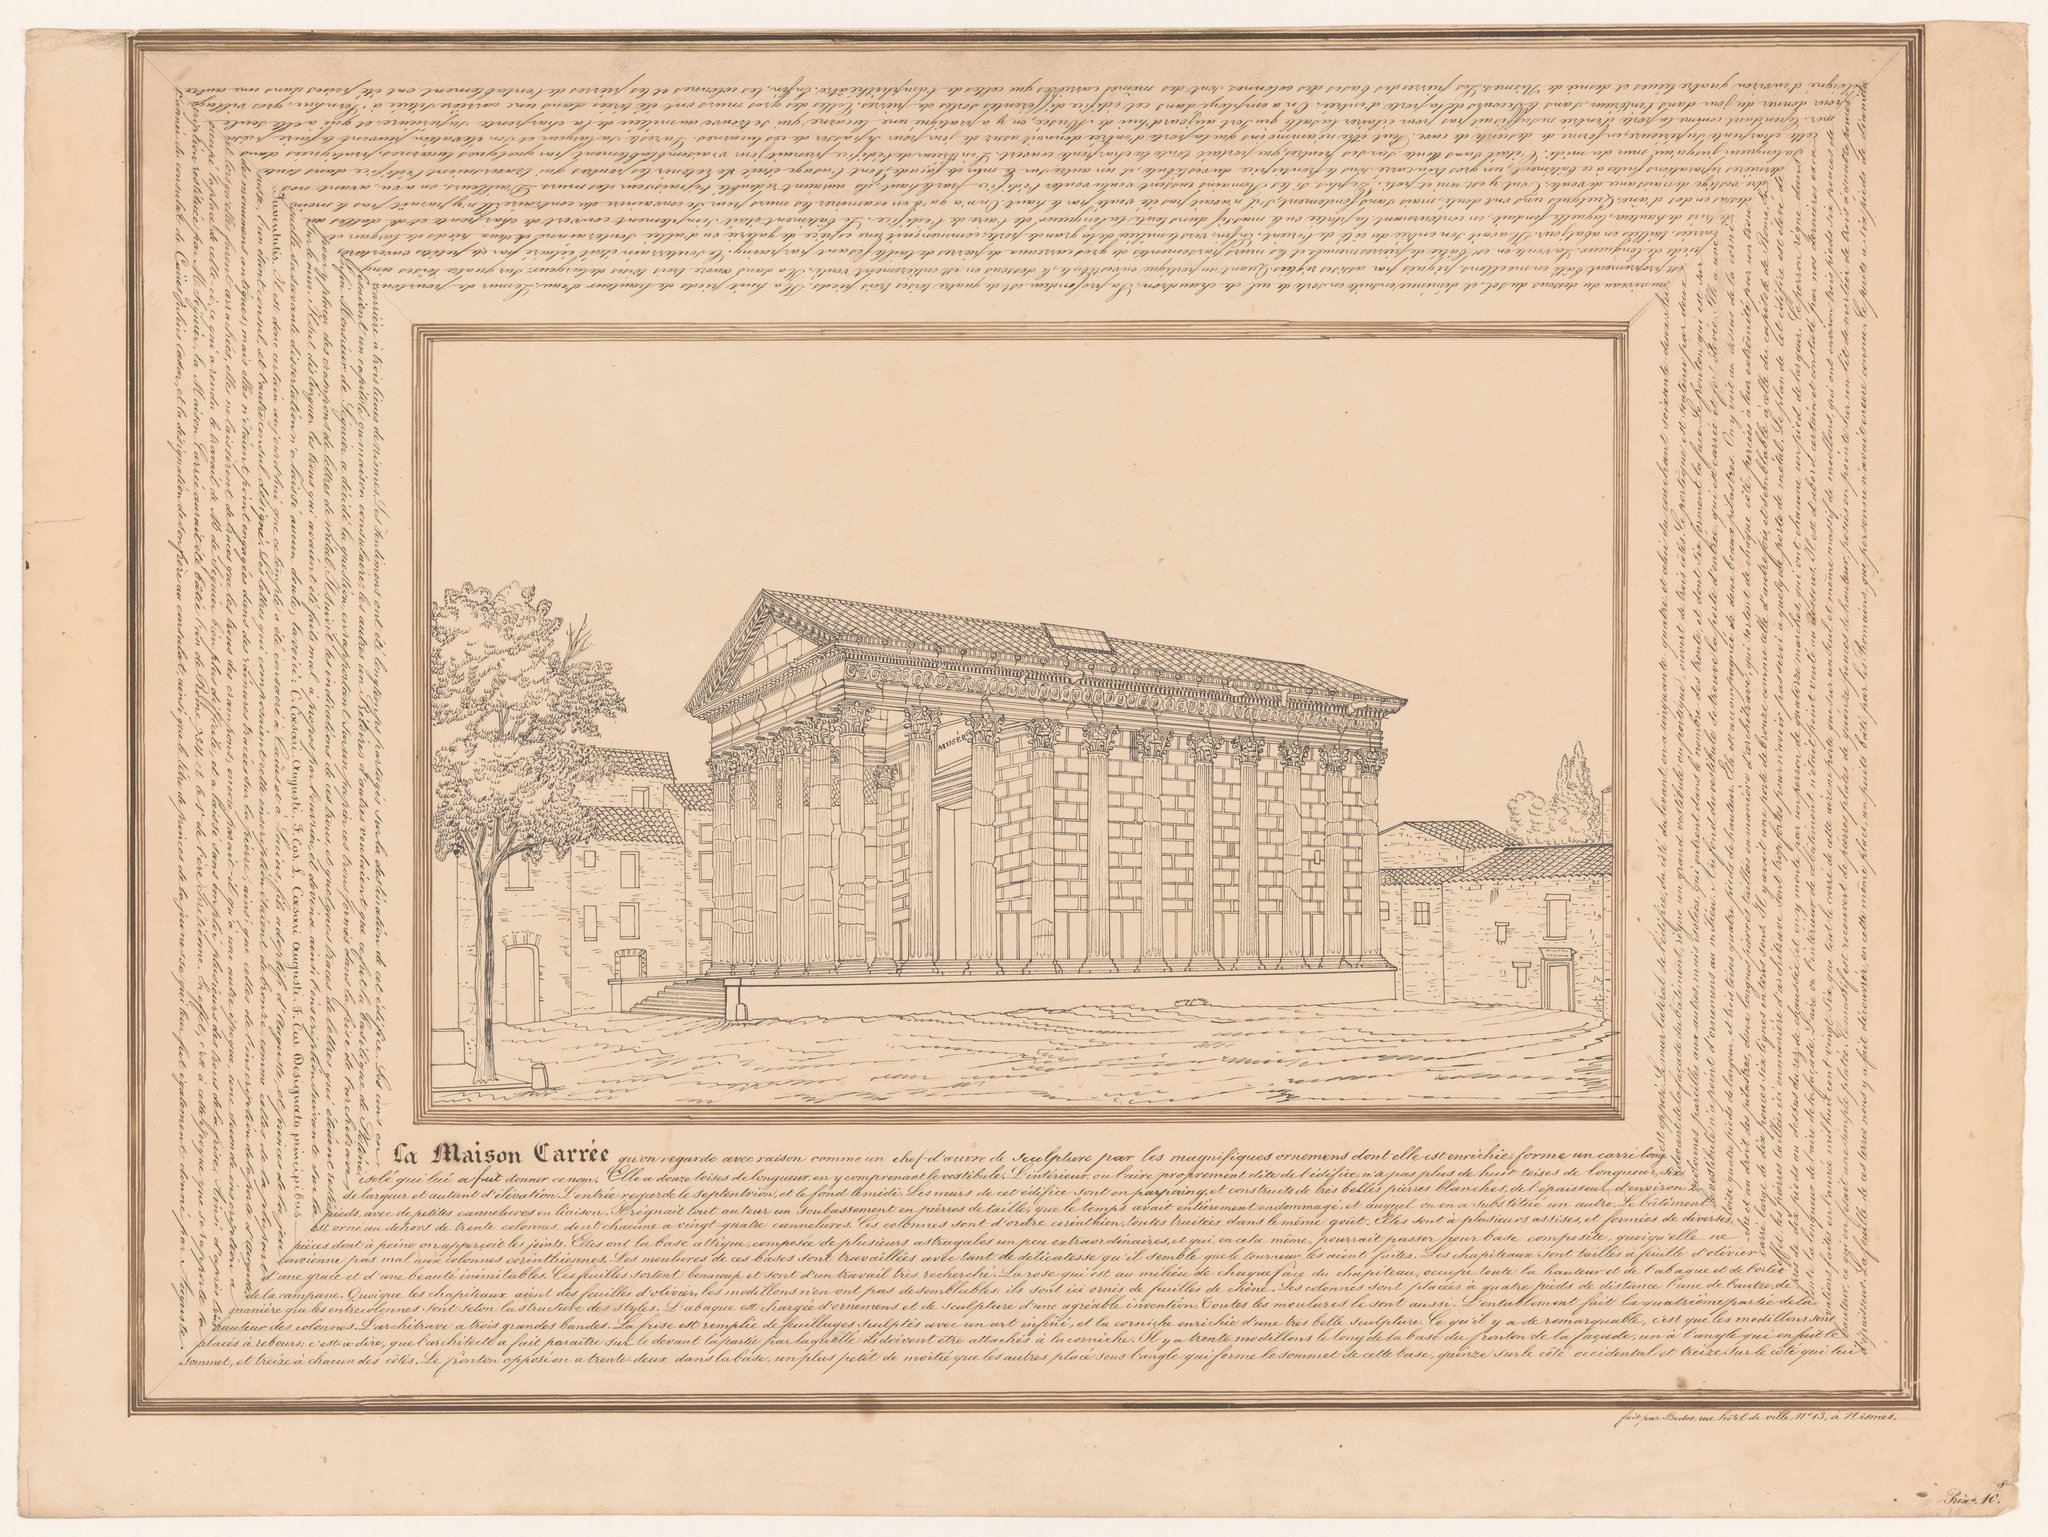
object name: drawing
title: La Maison Carrée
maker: bedos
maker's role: draughtsman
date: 1824-1907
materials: ink, paper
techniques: brush, pen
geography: nîmes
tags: temple, shrine ~ roman religion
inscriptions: collector's mark: Lugt 2228, inscription: ‘Prix. 10’